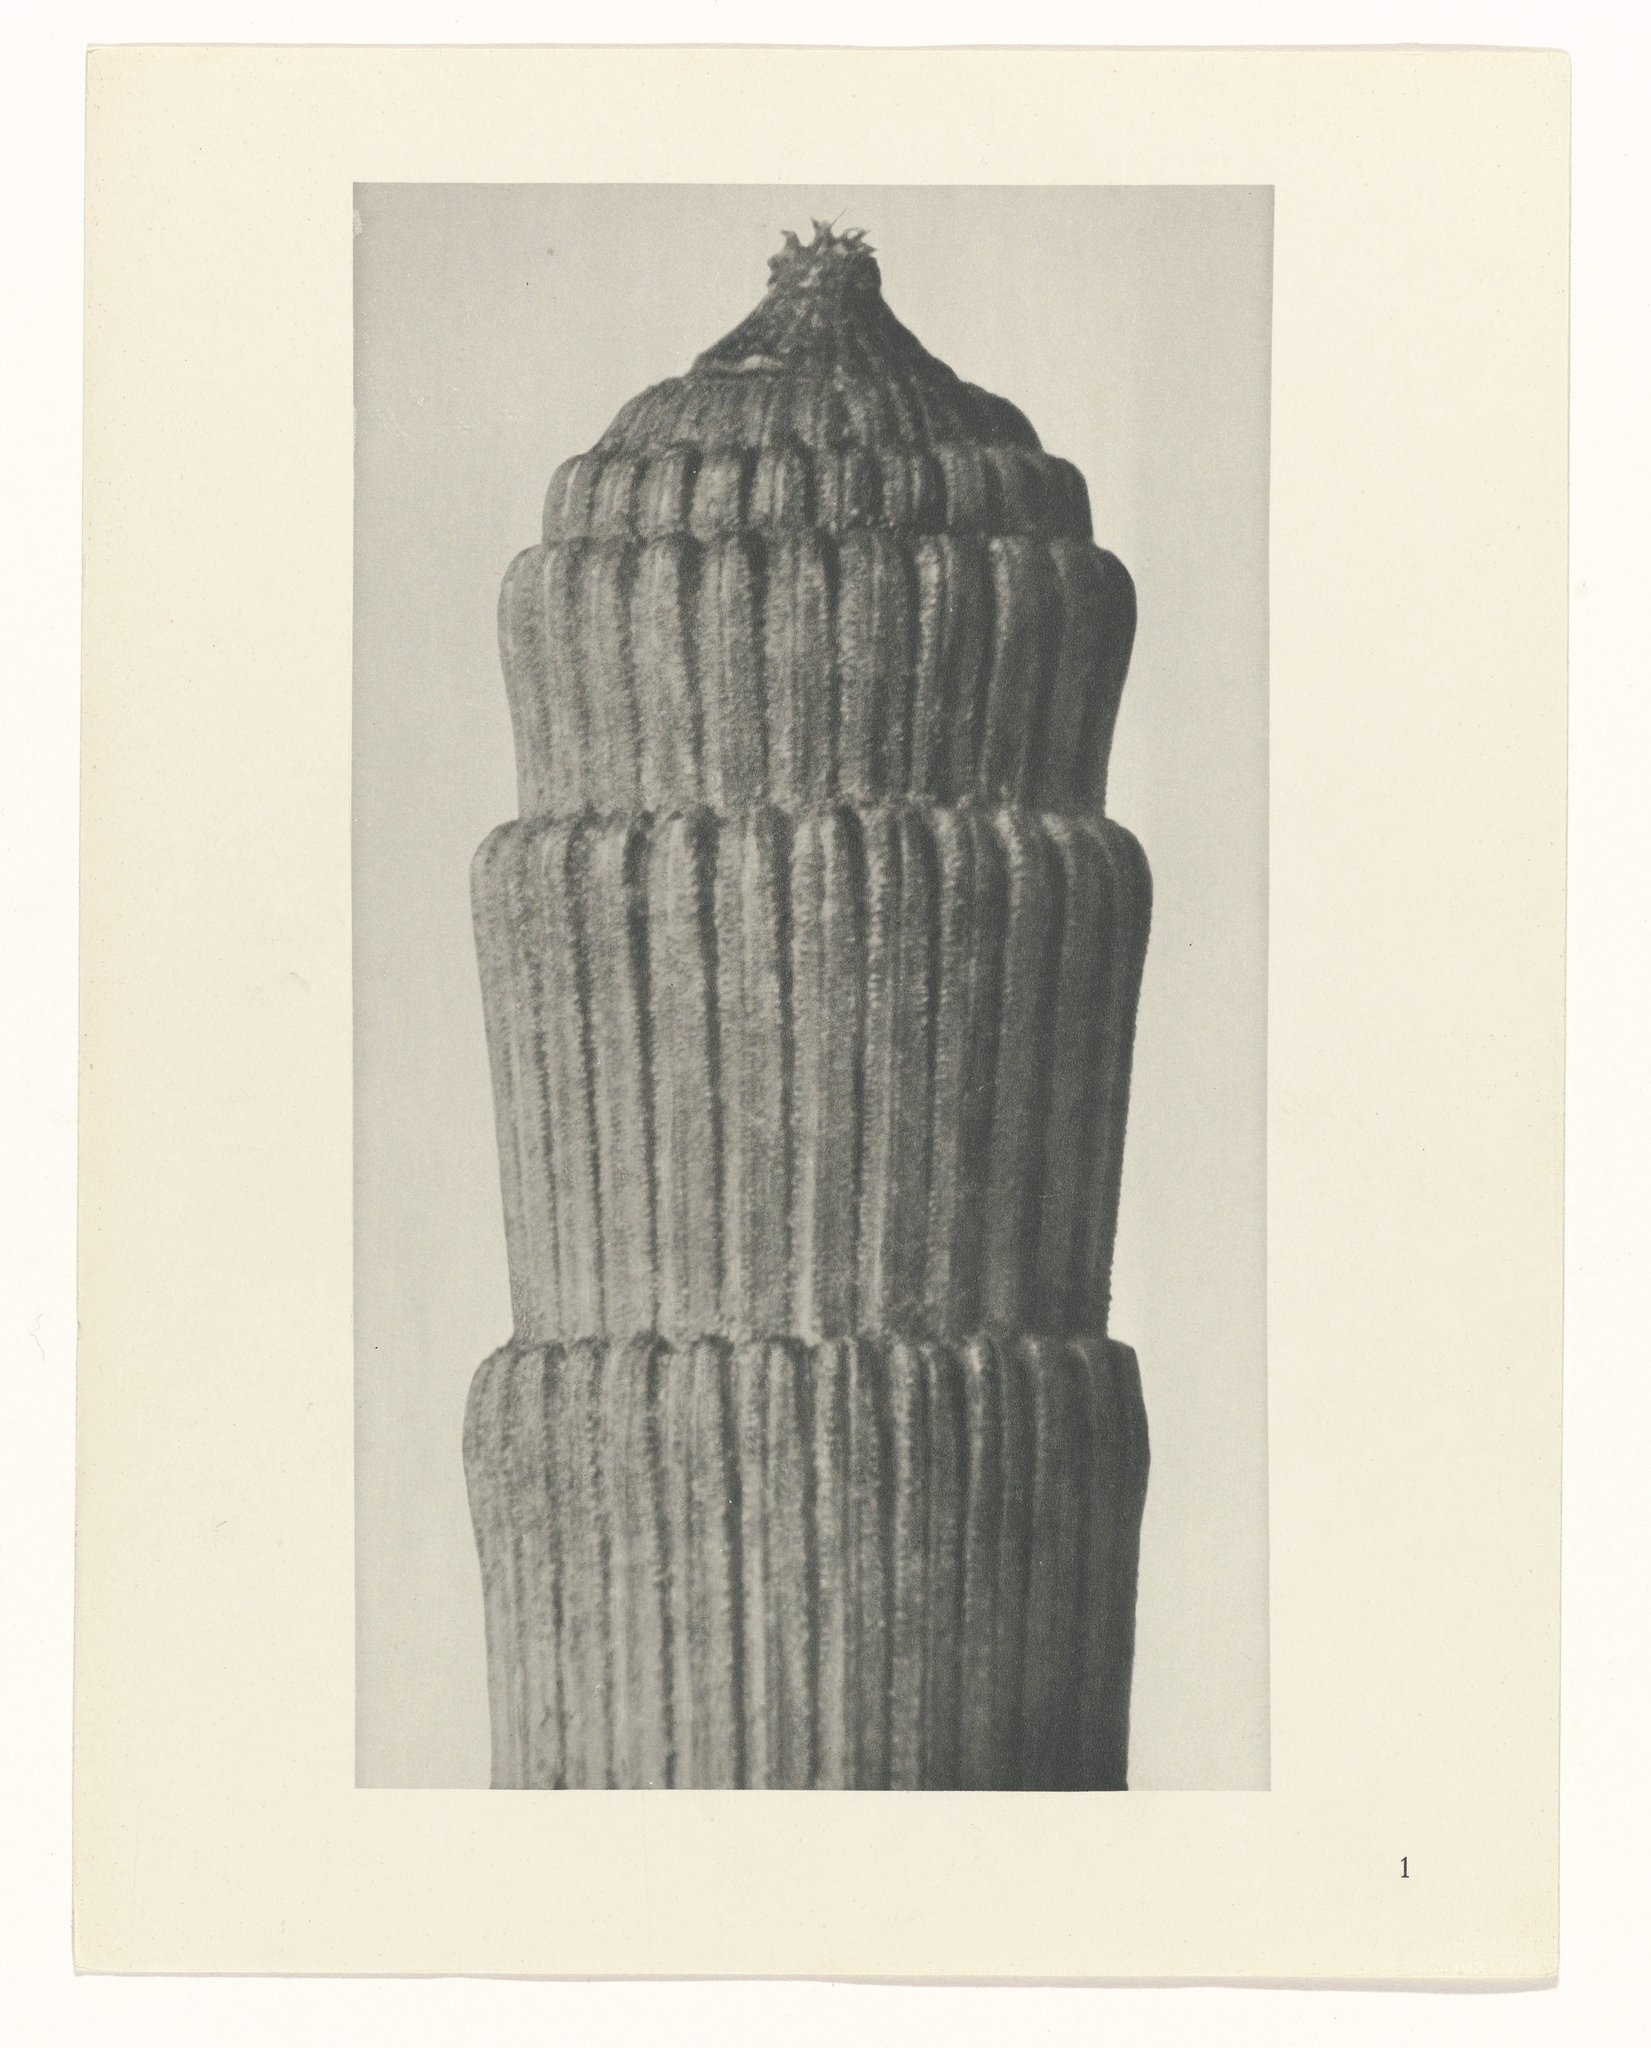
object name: photograph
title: Plantstudie, Equisetum hiemale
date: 1928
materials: ink, paper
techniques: rotogravure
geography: berlin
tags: plants (in general)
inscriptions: number: ‘1’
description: Equisetum hiemale. Winter-Schachtelhalm.Junger Spross in 25-facher Vergrößerung. Afkomstig uit losbladige uitgave.